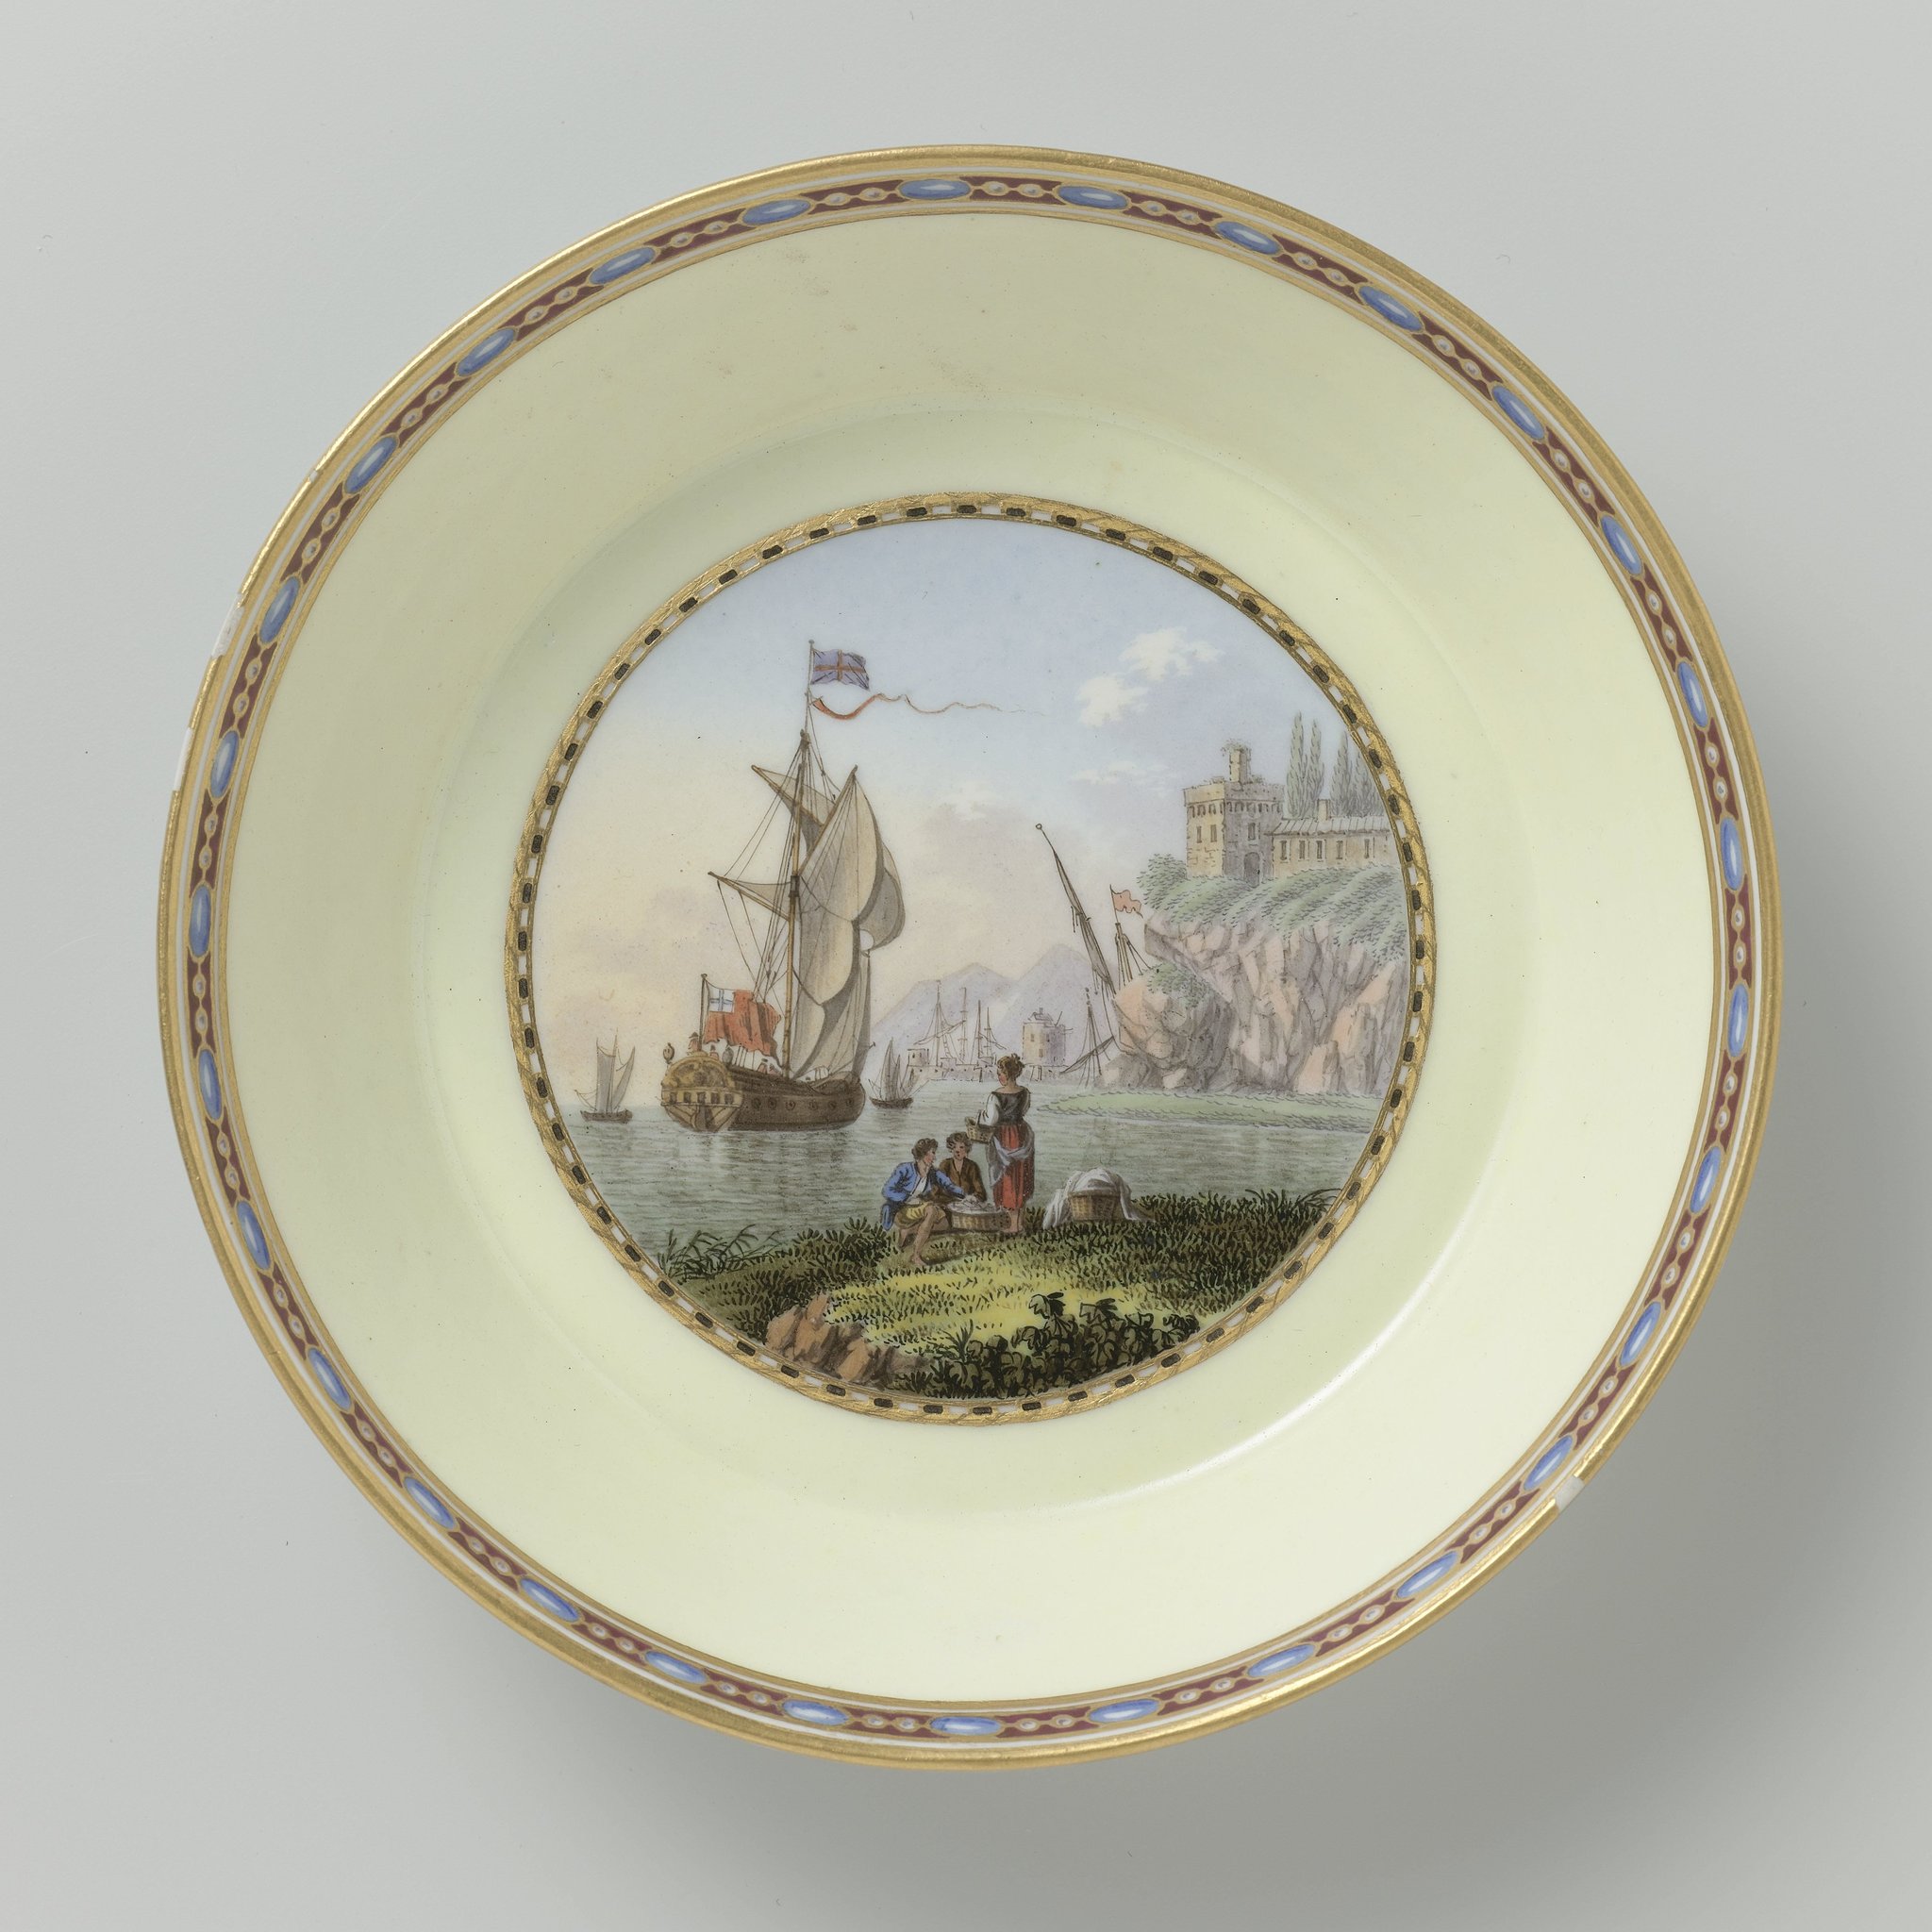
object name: eating drinking utensil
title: Schotel, veelkleurig beschilderd met een havengezicht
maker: johann gottlob karl liebezeit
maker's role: porseleinschilder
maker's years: 1766-1814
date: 1804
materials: porcelain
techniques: painted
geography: meissen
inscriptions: mold mark, factory mark, painter's mark: ‘115’, mark: ‘4’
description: Déjeuner (small tea or coffee set) with views of Mediterranean ports. On the tray a view ofthe harbour at Marseille. Porcelain. Meissen, dated 1804.